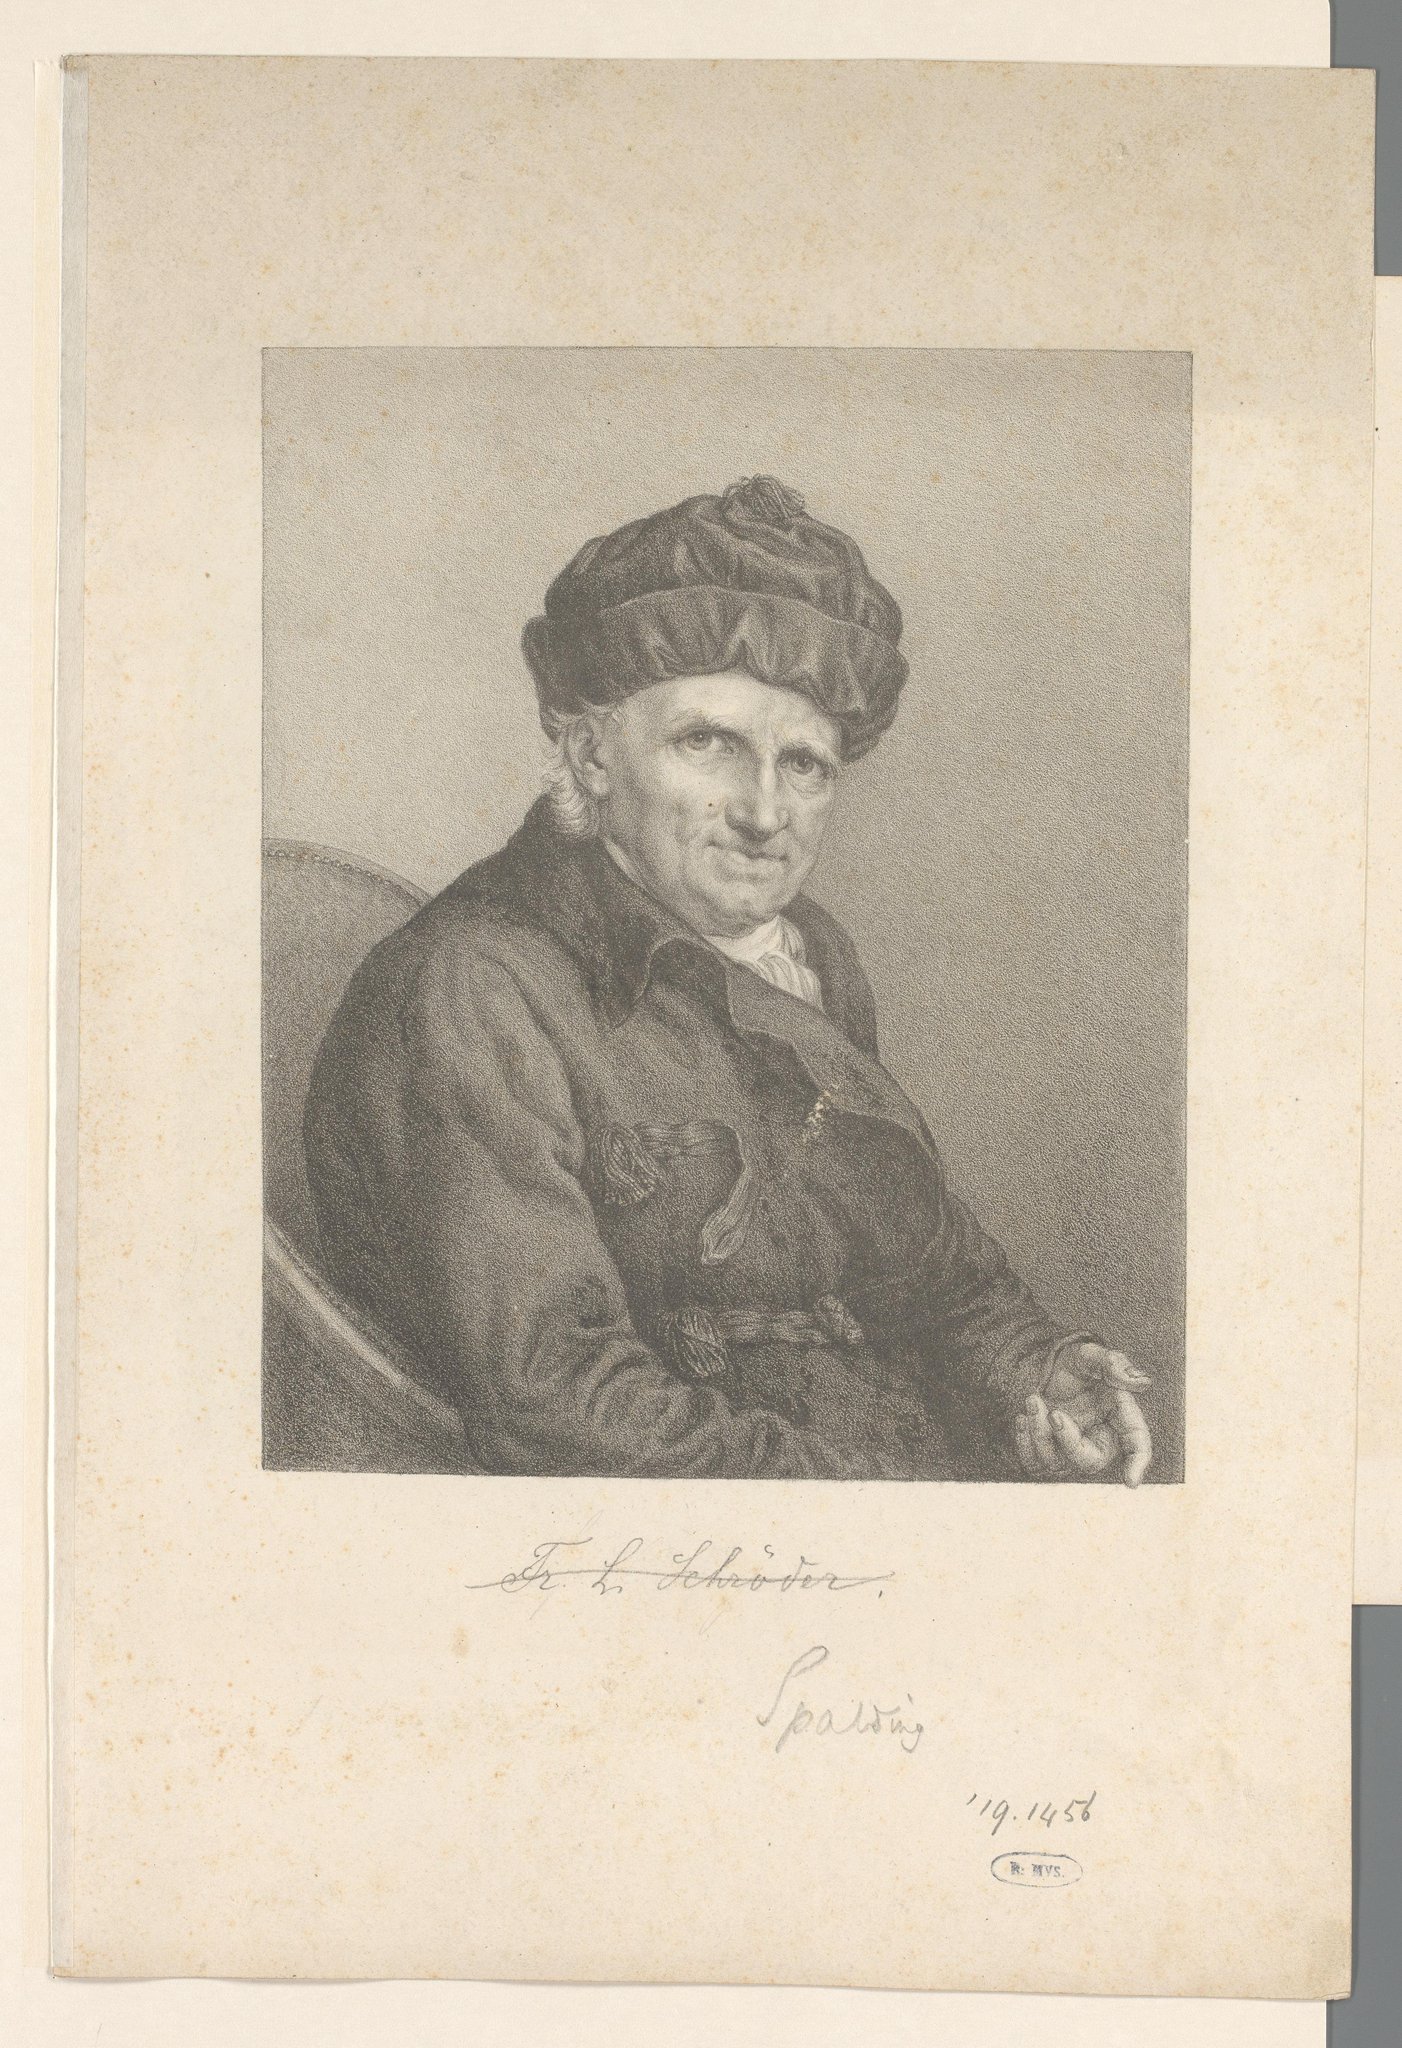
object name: print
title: Portret van Johann Joachim Spalding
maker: maas (graveur)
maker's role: print maker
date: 1809-1899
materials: paper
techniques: lithograph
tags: berlin, johann joachim spalding, head-gear, historical persons (+ (full) bust portrait)